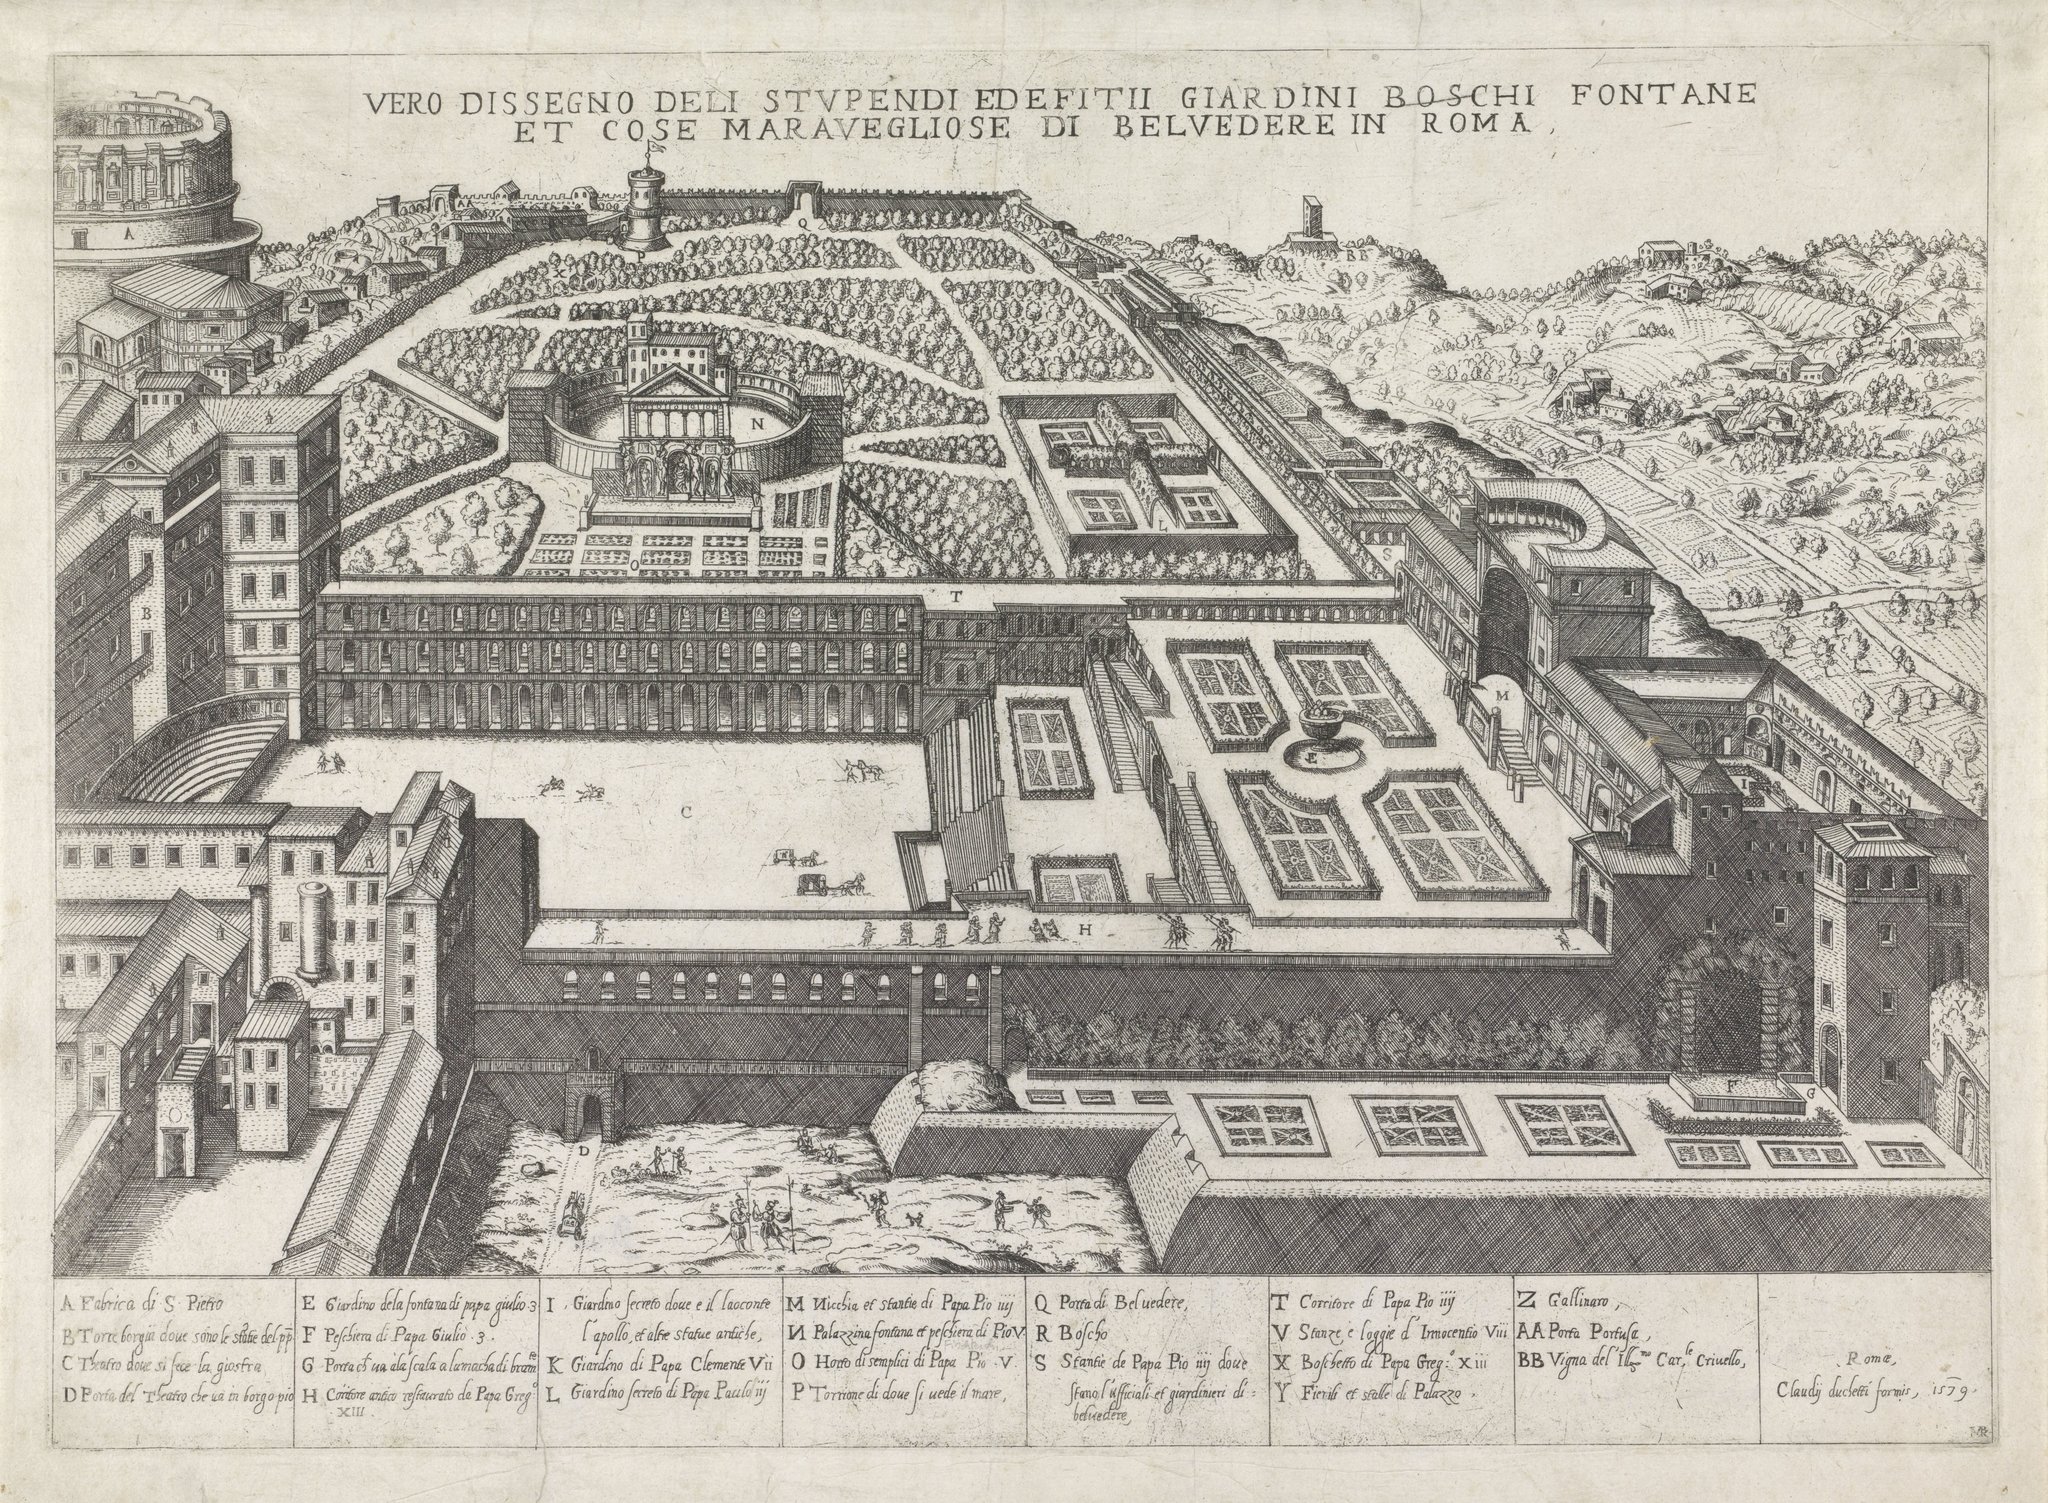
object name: print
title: Vero dissegno degli stupendi edifitii giardini boschi fontane et cose meravegliose di Belvedere in Roma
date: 1579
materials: paper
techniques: etching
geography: rome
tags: garden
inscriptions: collector's mark: Lugt 2228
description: Gezicht in vogelperspectief op de Cortile del Belvedere met links de Sint-Pietersbasiliek en rechts de Belvedere (een voormalige villa en binnenhof van het Apostolisch Paleis in Vaticaanstad). Verklarende lijst met letters in de ondermarge.